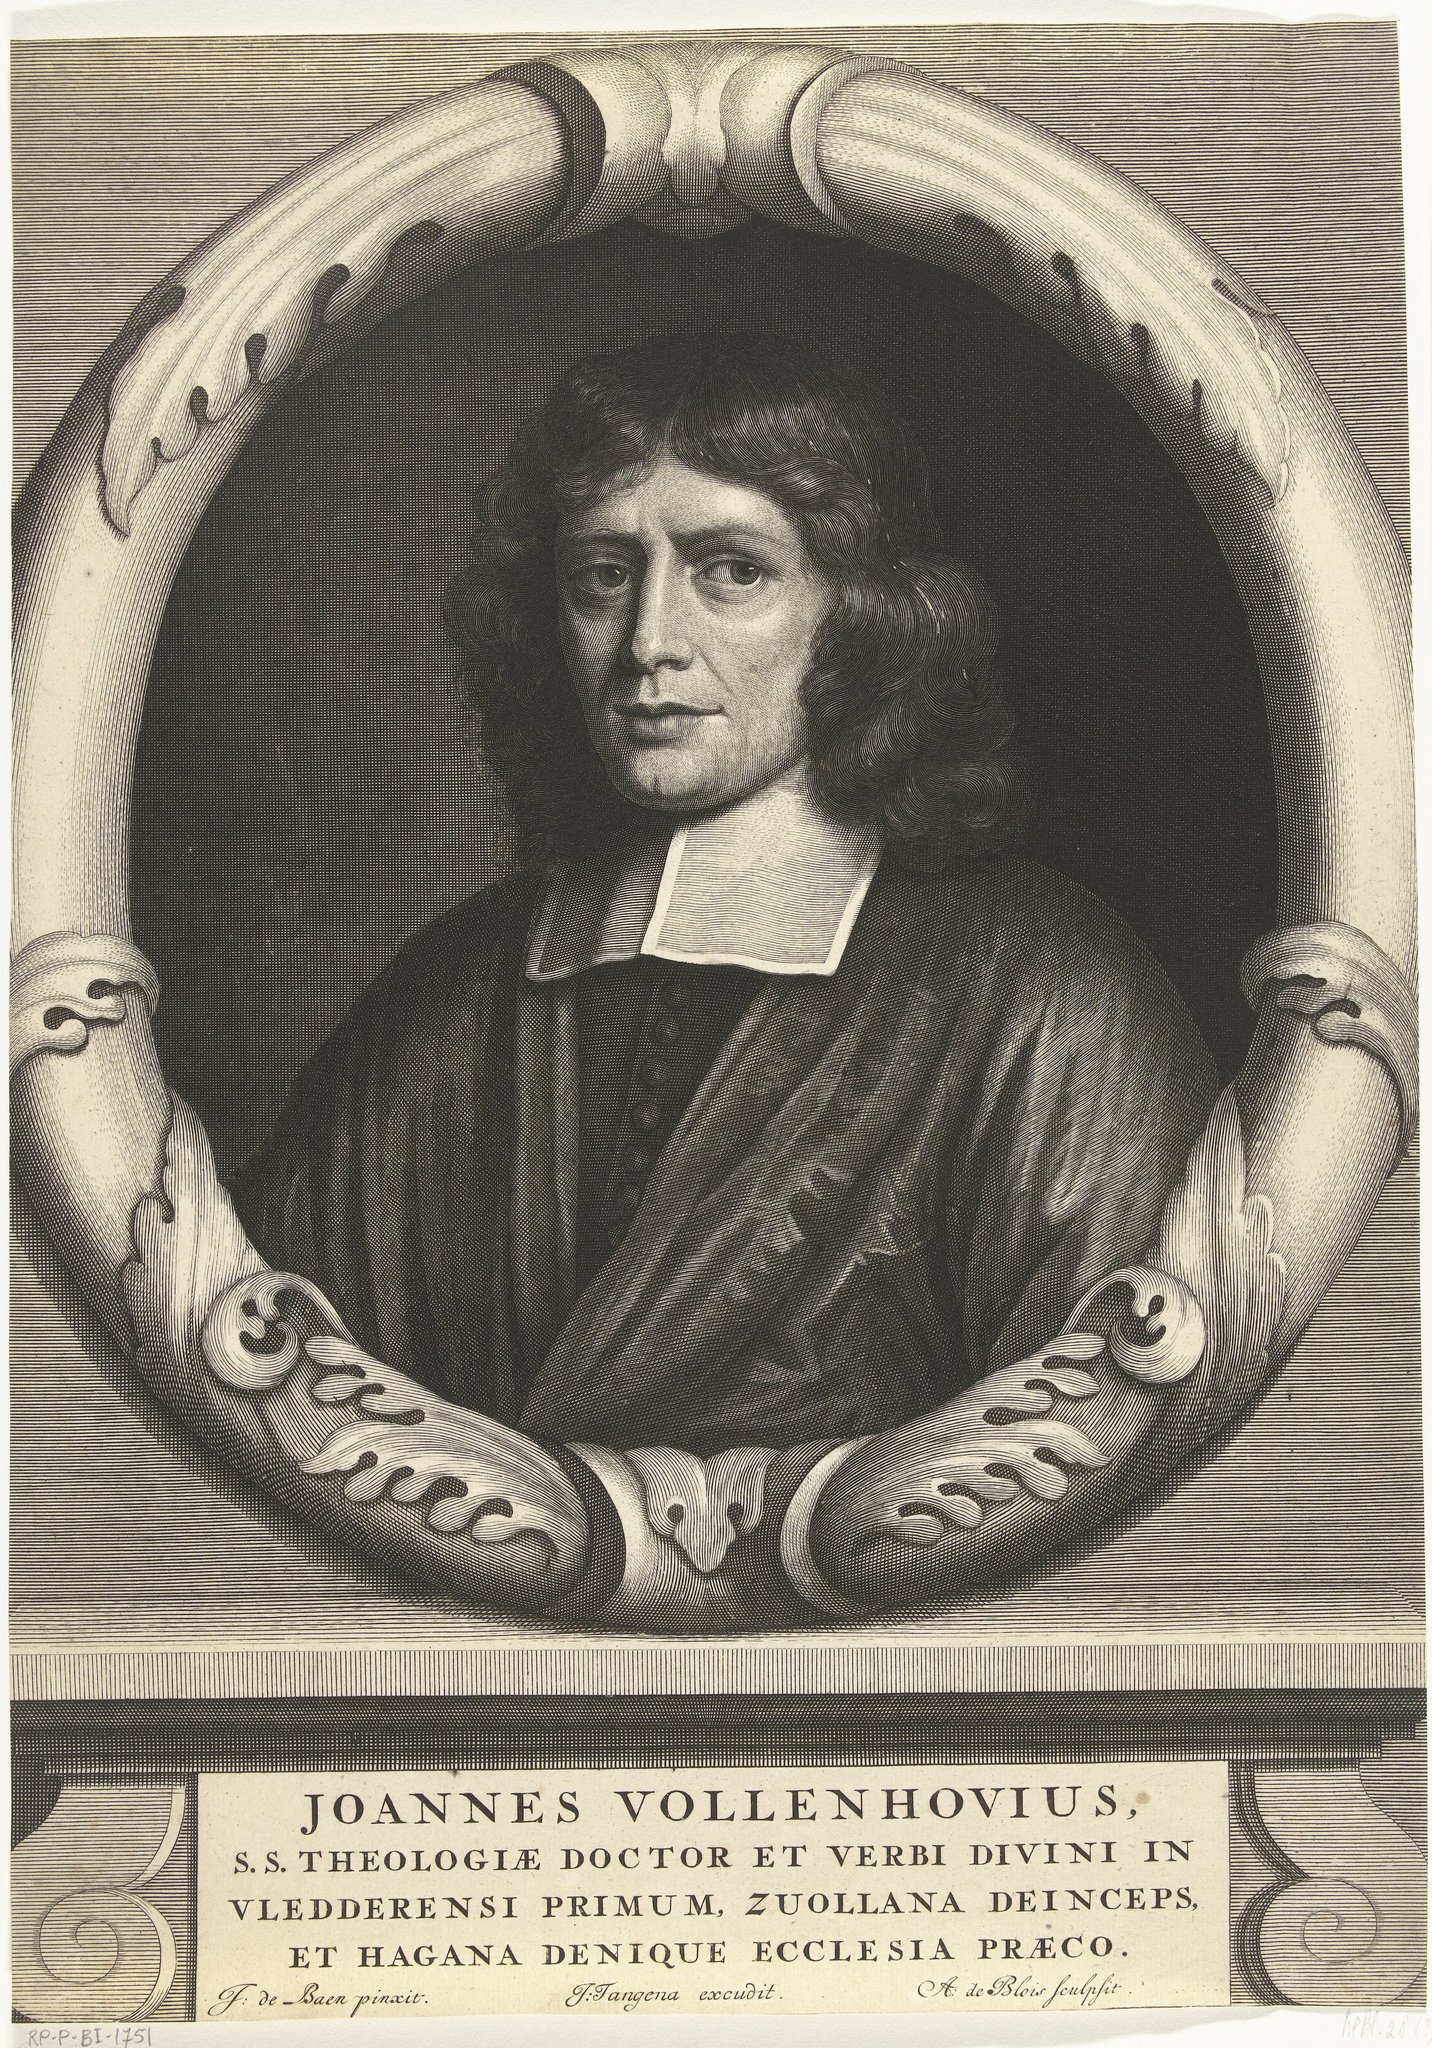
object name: print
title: Joannes Vollenhovius, s.s. theologiae (...) denique ecclesia praeco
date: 1679-1717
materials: paper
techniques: engraving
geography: amsterdam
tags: the hague, functionaries and dignitaries (with name) ~ episcopal protestant churches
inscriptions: collector's mark: Lugt 2228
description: Portret van predikant en dichter Joannes Vollenhove, buste naar links in ovale omlijsting met bladornamenten.